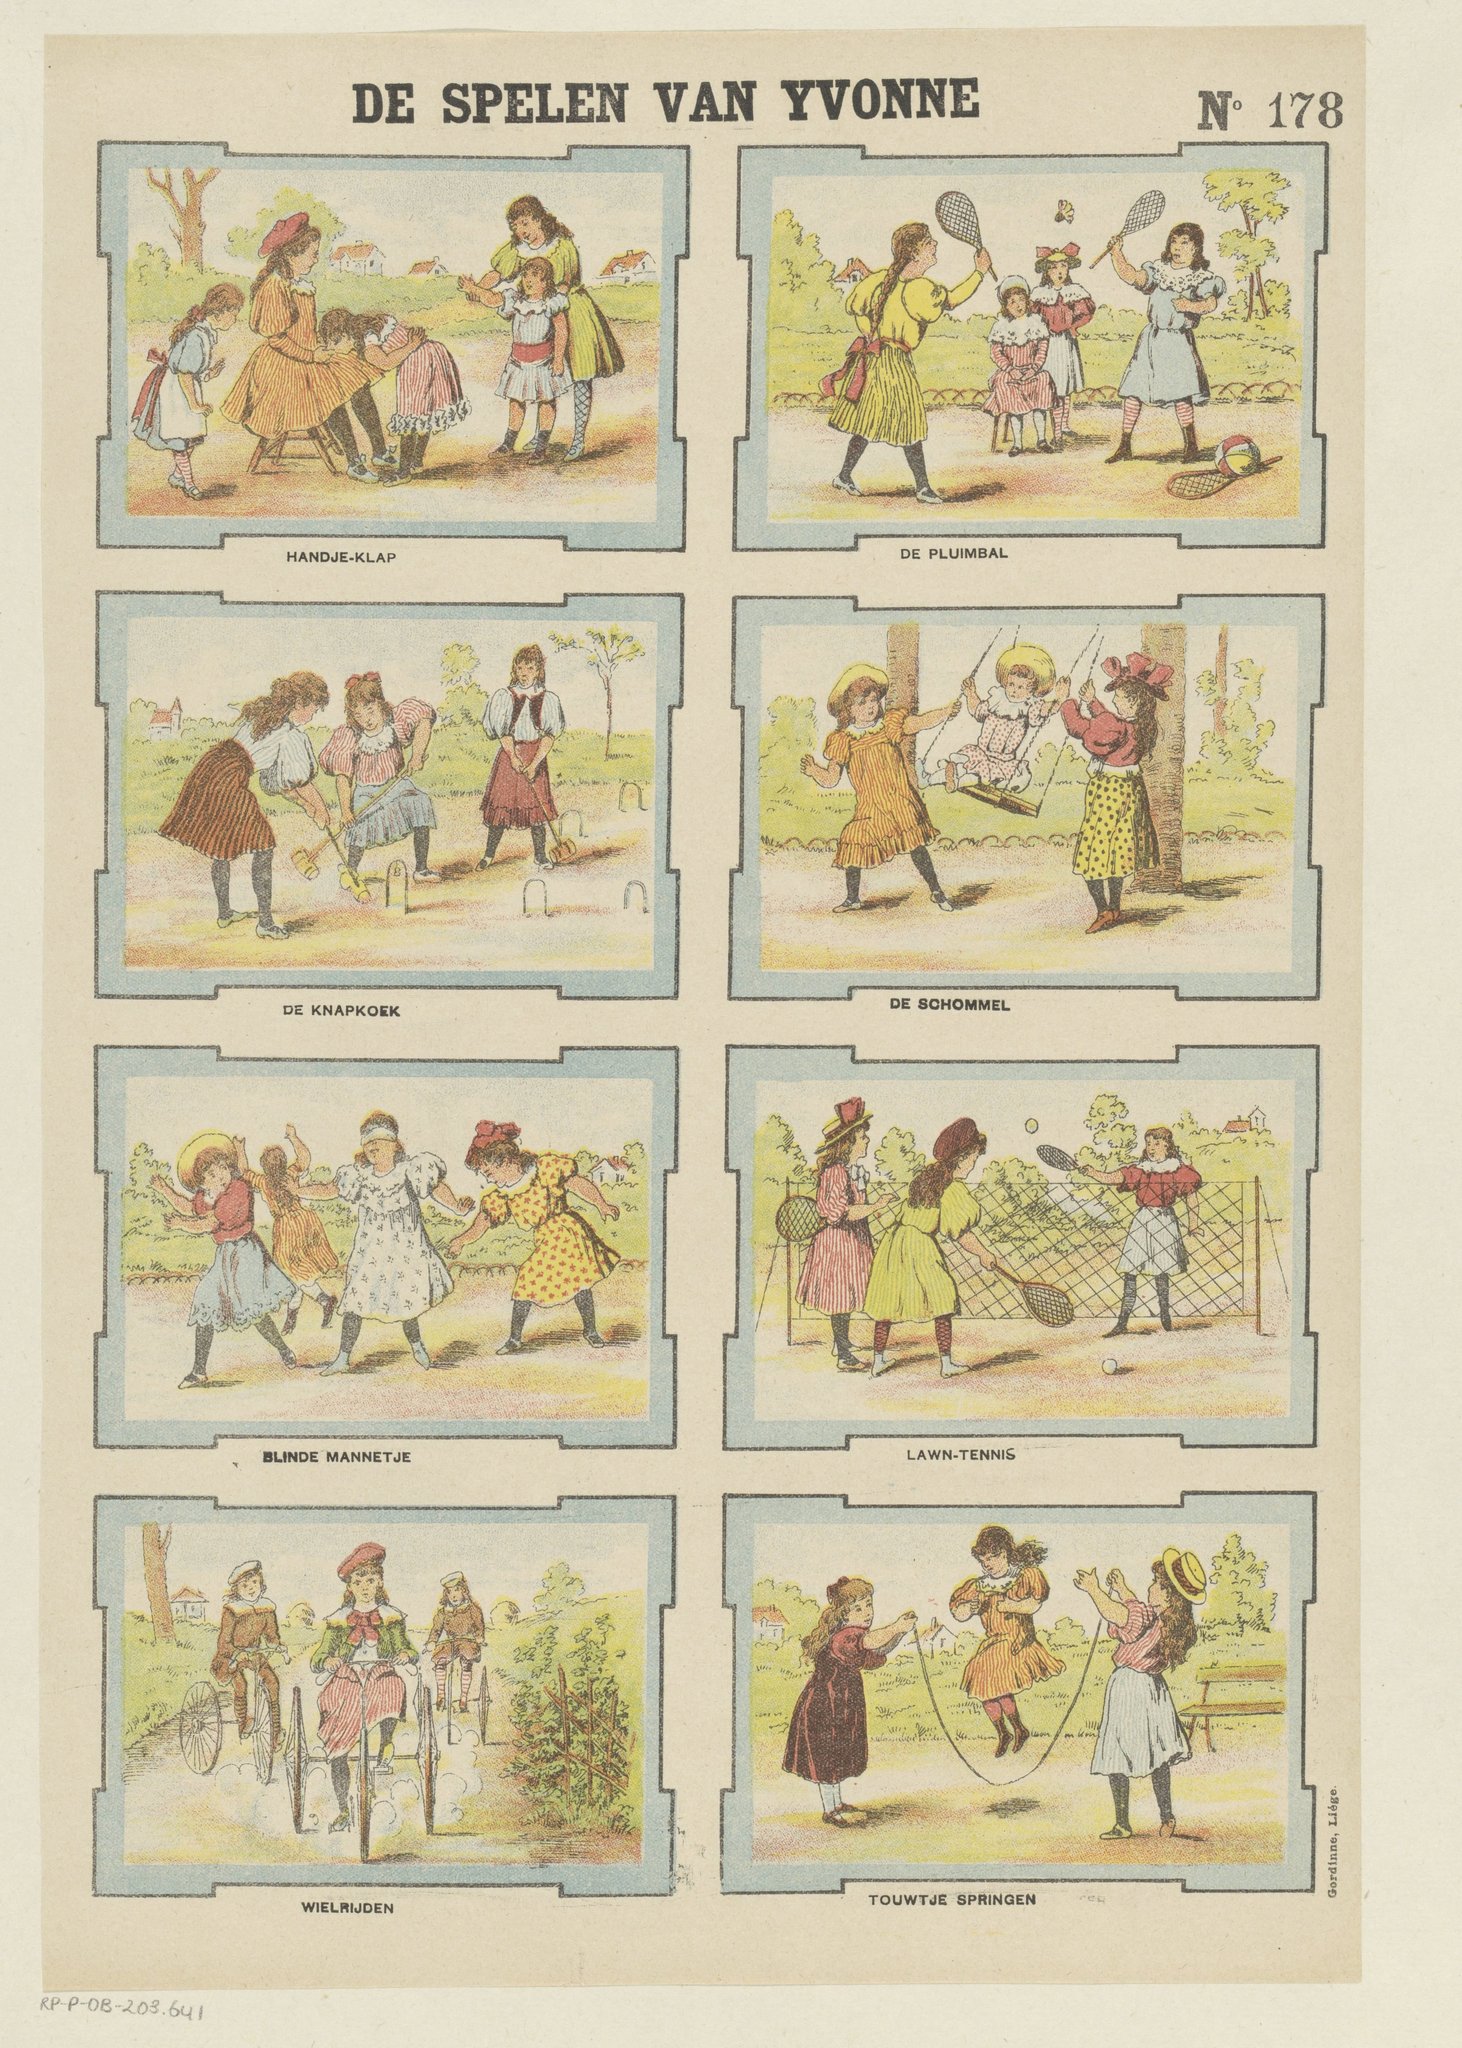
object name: popular print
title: De spelen van Yvonne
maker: Anonymous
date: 1894-1959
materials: paper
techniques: lithograph, letterpress printing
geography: liège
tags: tennis, lawn-tennis, children's games and plays, blind-man's buff, swinging (children's game), jumping-rope games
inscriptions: collector's mark: Lugt 2760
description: Blad met 8 voorstellingen van kinderspelen, zoals schommelen, blindemannetje en touwtjespringen. Onder elke afbeelding een onderschrift. Genummerd rechtsboven: No 178.